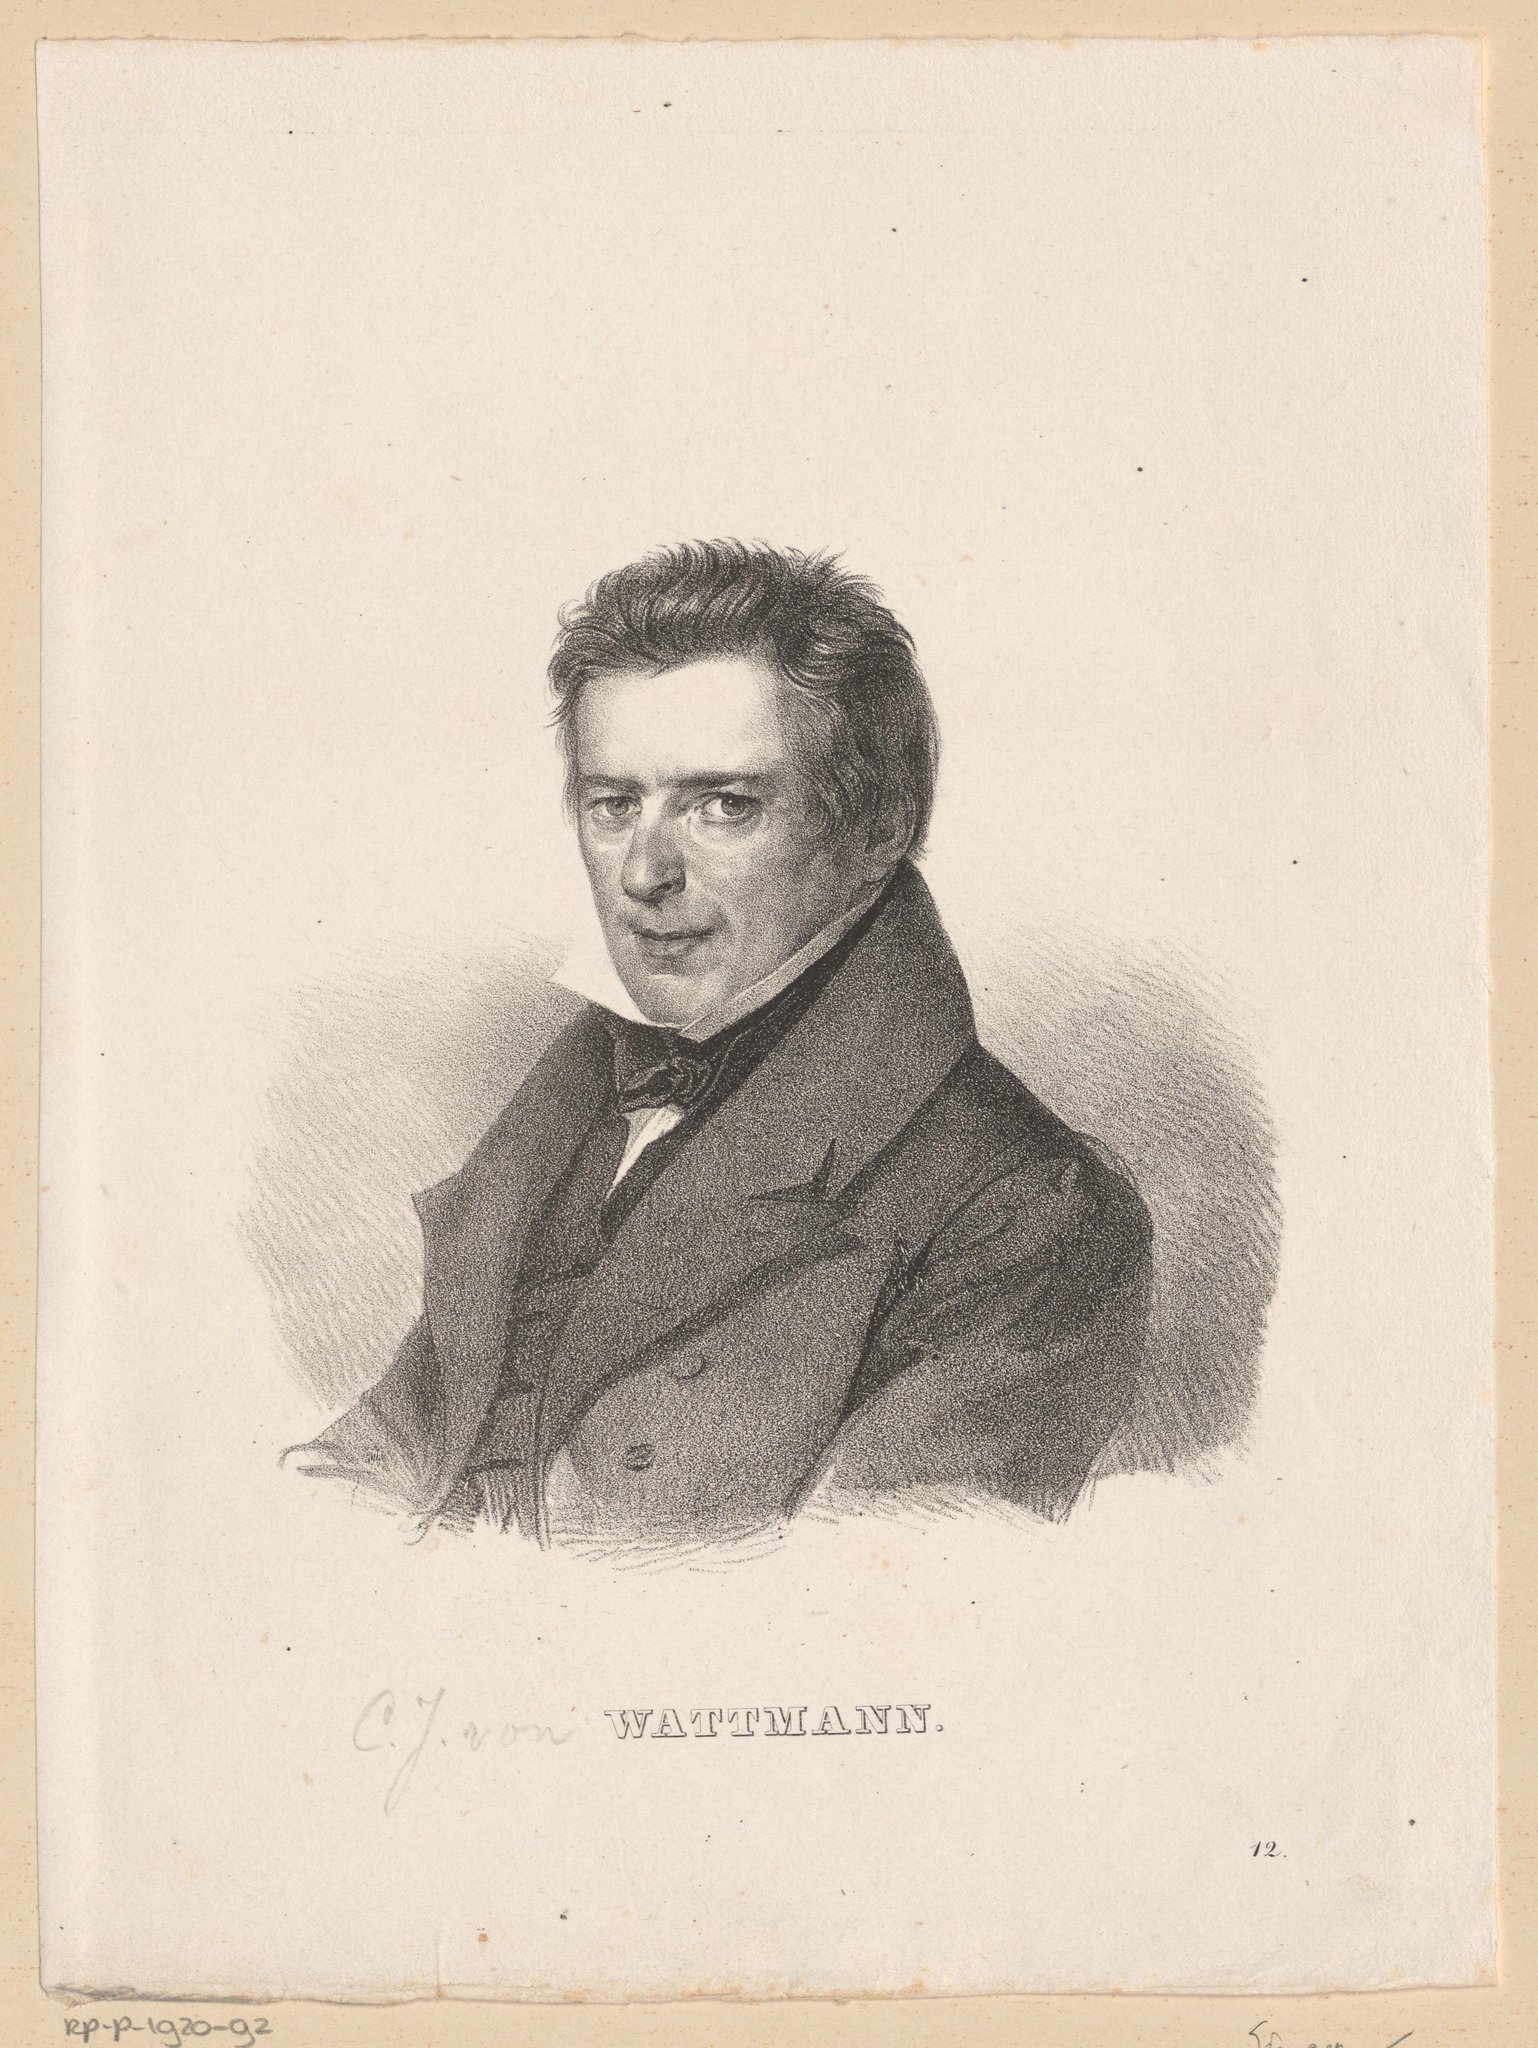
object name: print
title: Portret van Joseph von Wattmann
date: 1837-1838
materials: paper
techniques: lithograph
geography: vienna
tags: historical persons, physician, doctor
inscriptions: collector's mark: Lugt 2228